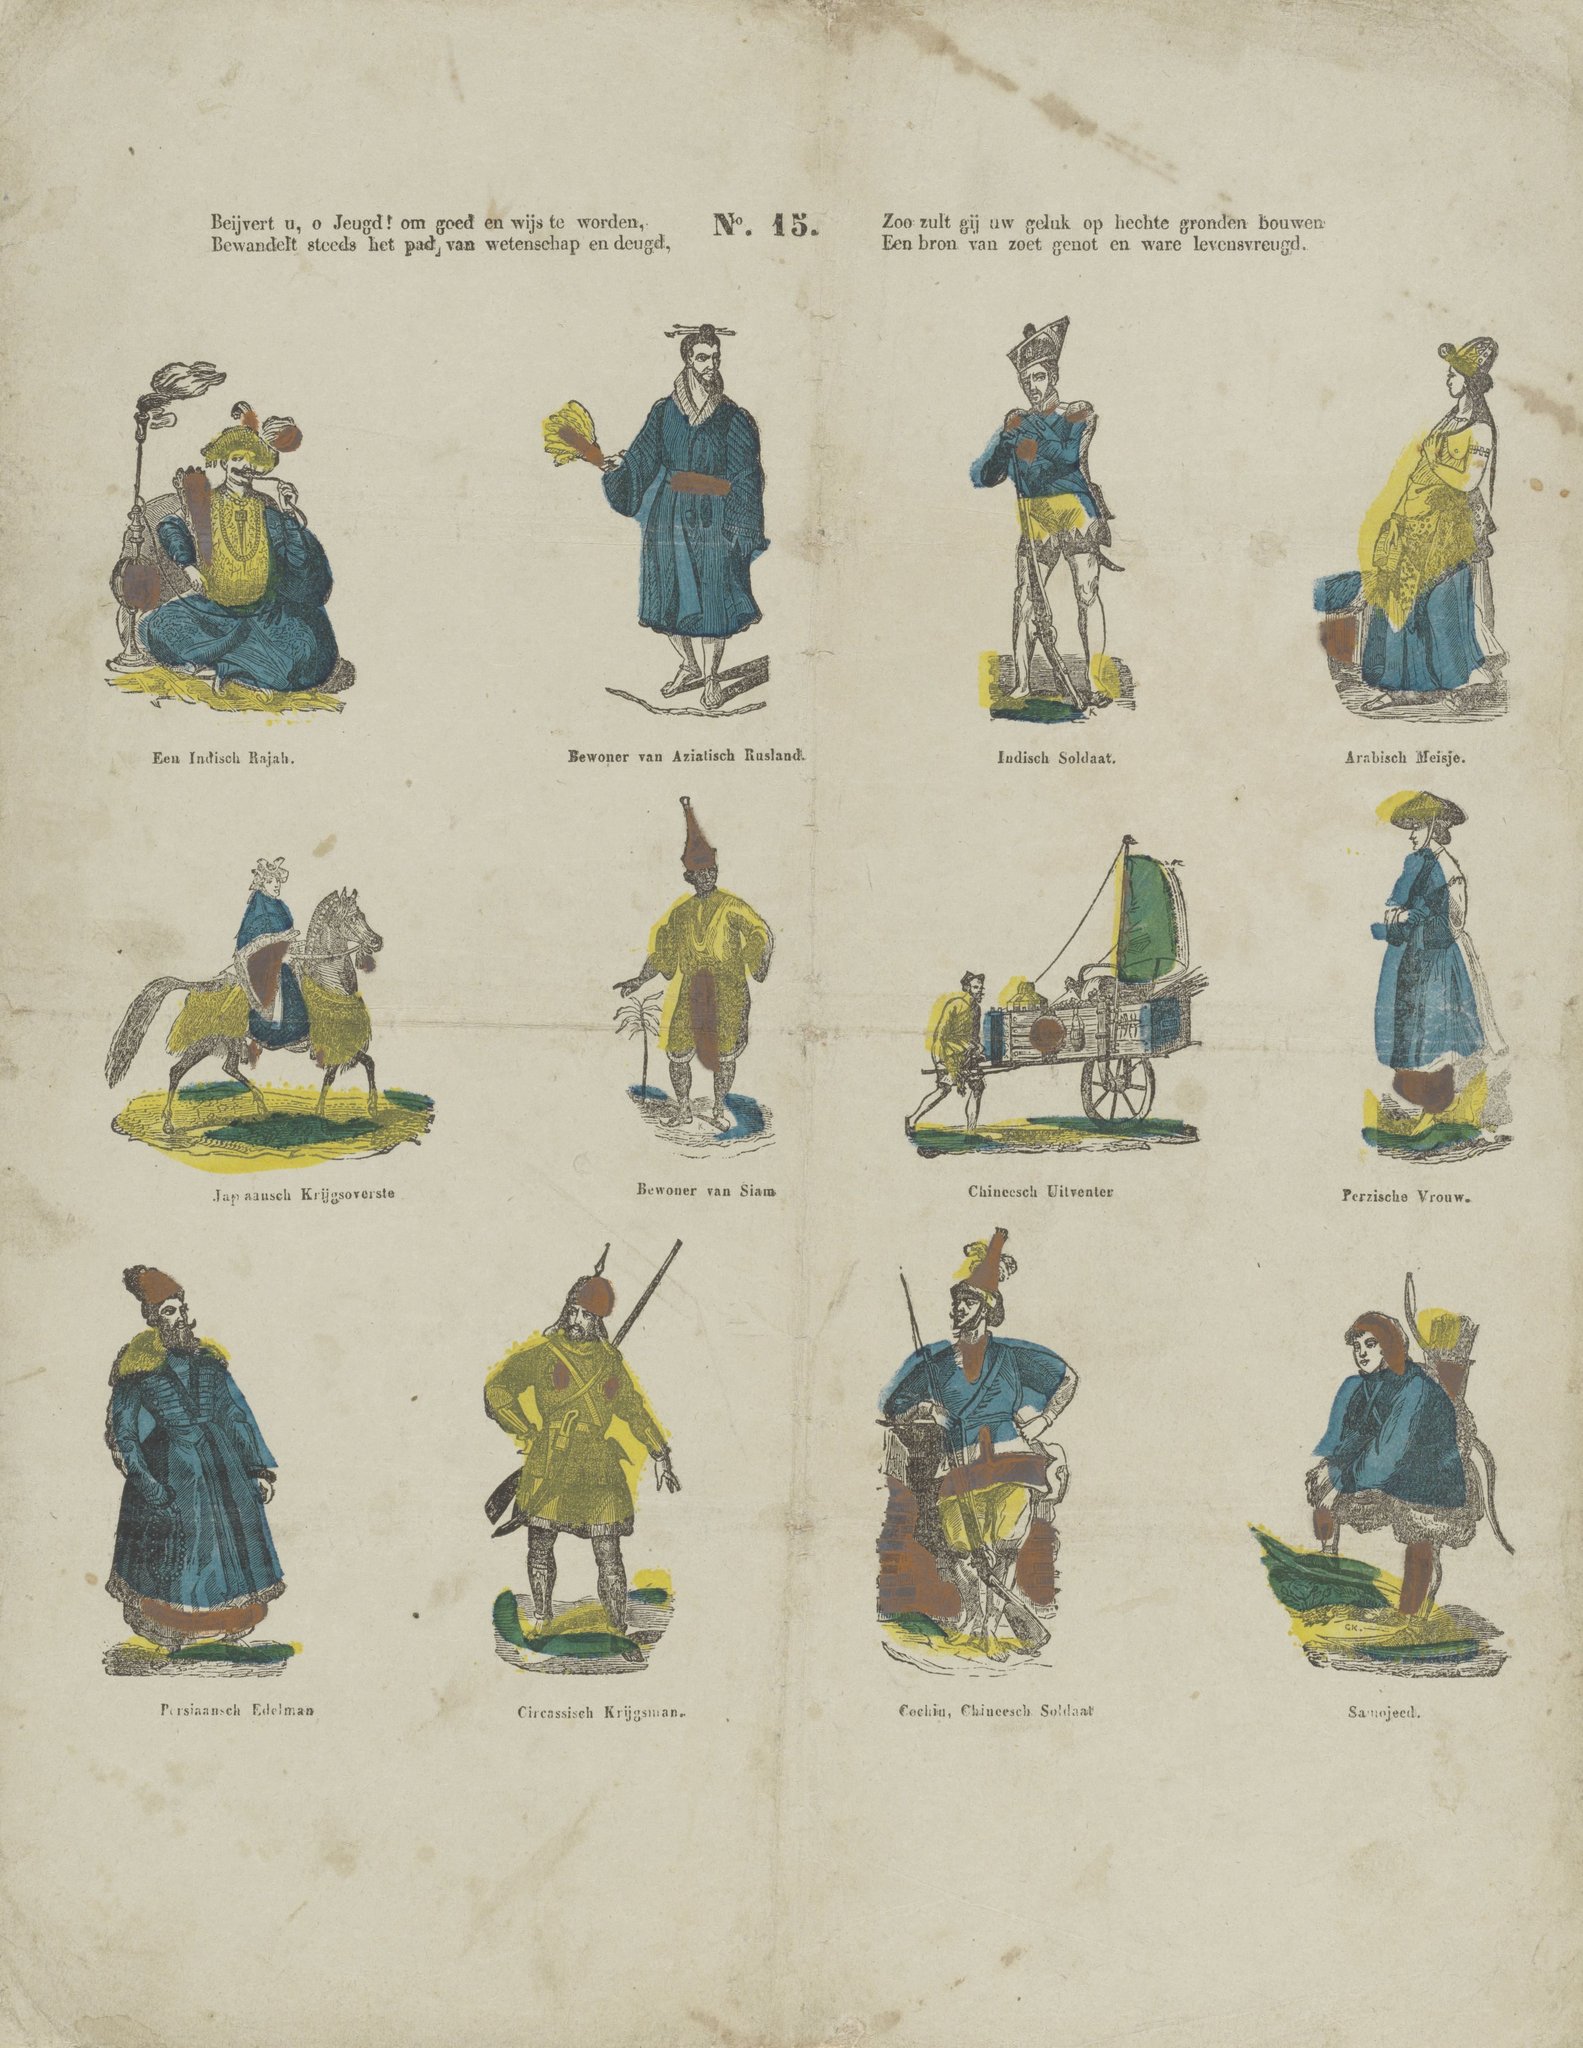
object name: popular print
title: Beijvert u, o jeugd! om goed en wijs te worden, / Bewandelt steeds het pad van wetenschap en deugd, / Zoo zult gij uw geluk op hechte gronden bouwen / Een bron van zoet genot en ware levensvreugd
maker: Anonymous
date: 1848-1881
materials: paper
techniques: colour, letterpress printing, engraving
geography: den bosch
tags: asiatic races and peoples, human types, characters (human types)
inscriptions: collector's mark: Lugt 2760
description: Blad met 12 voorstellingen van verschillende figuren uit het Oosten. Onder elke afbeelding een onderschrift. Genummerd midden boven: No. 15.